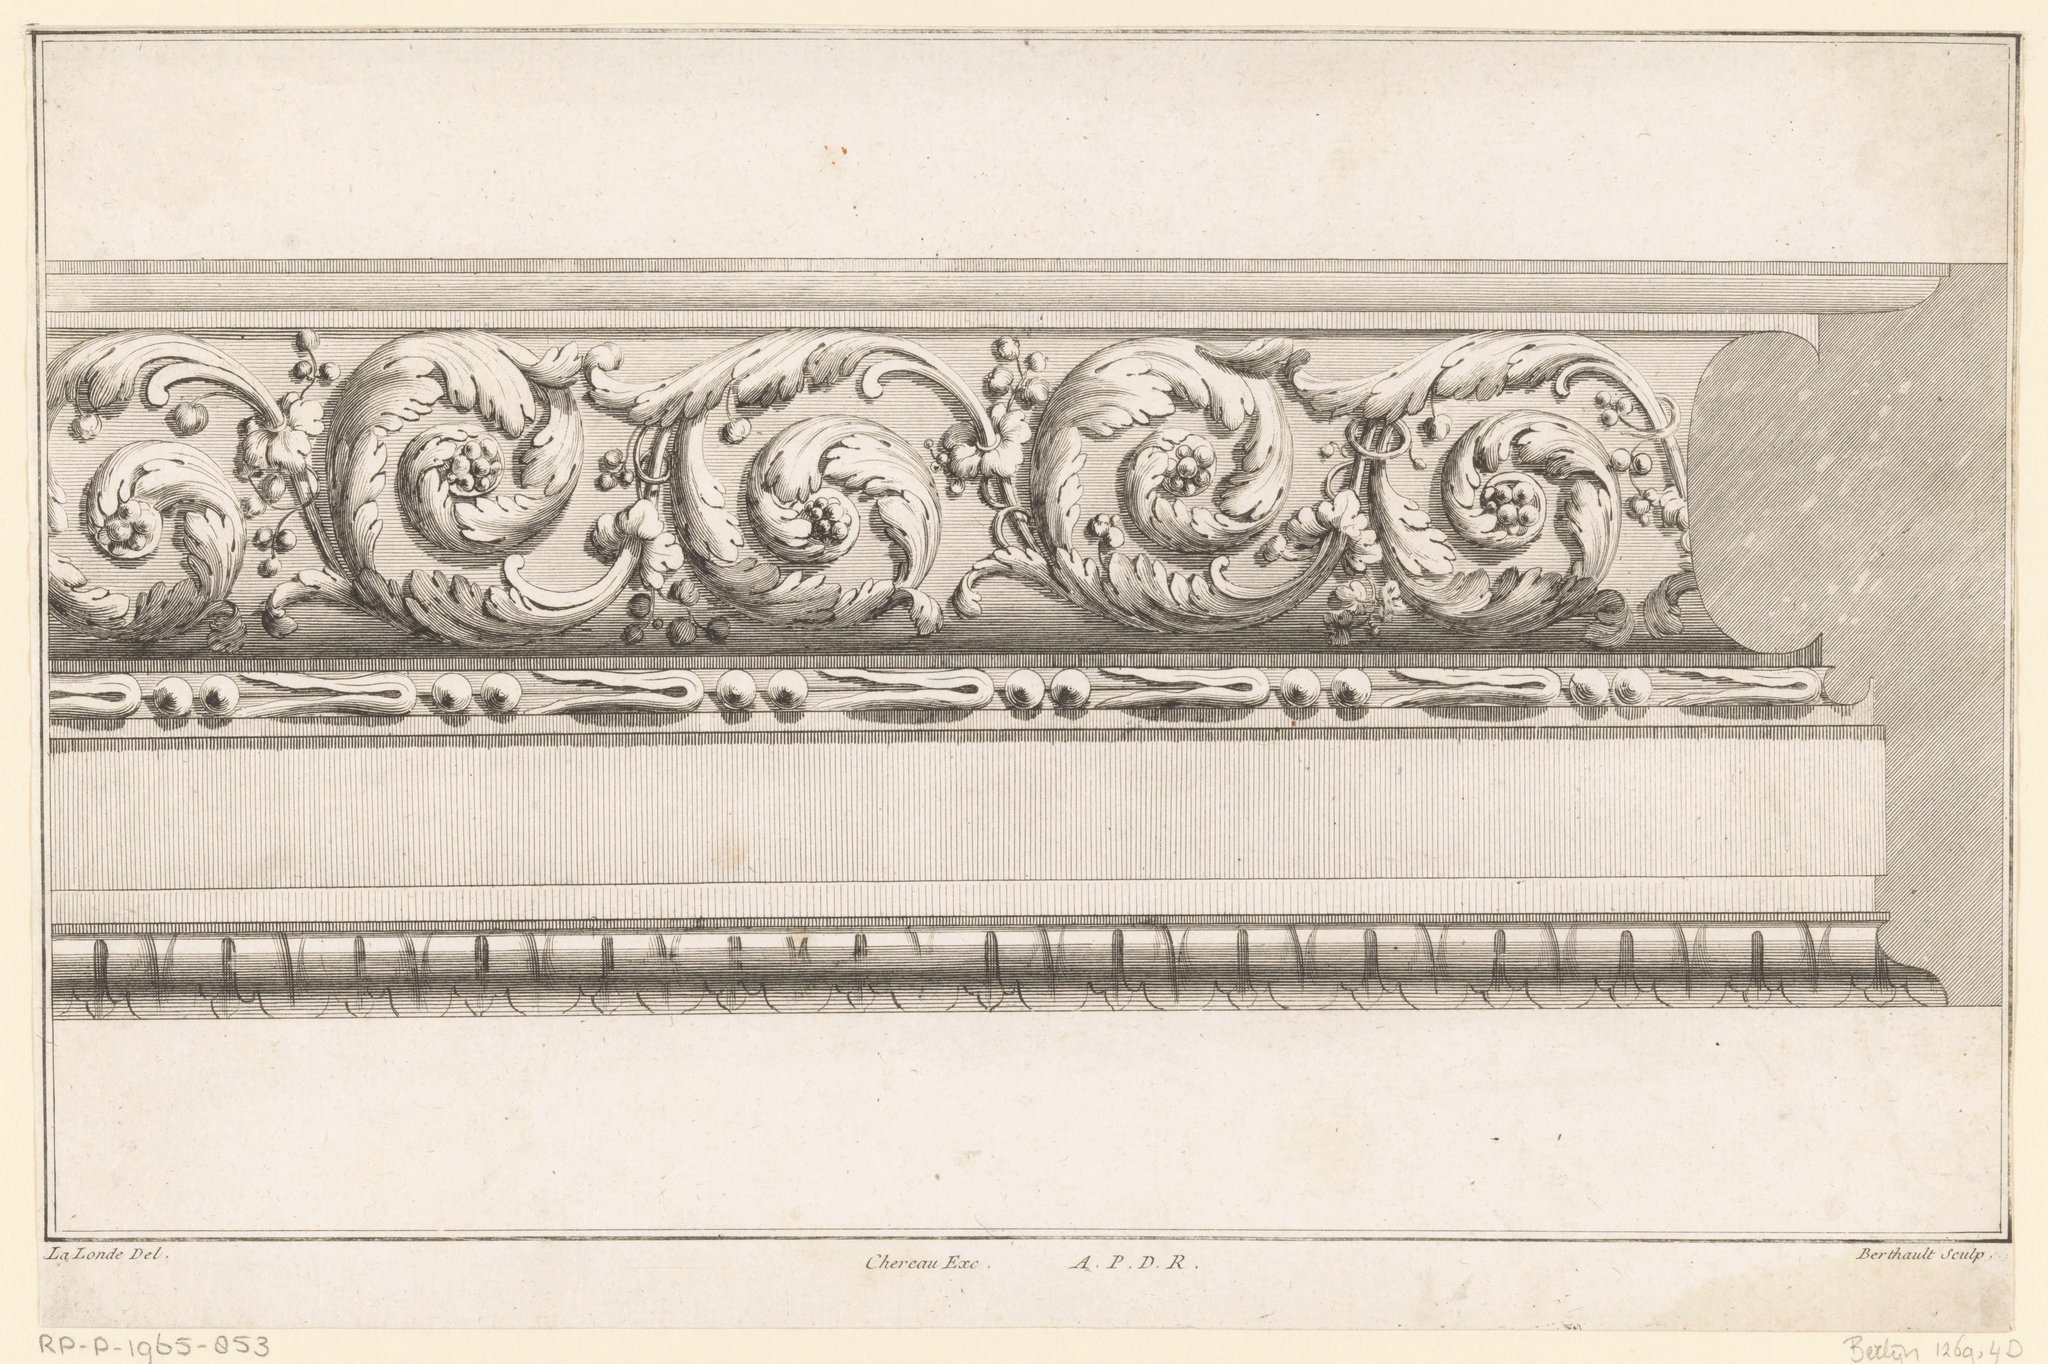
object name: print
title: Lijst blad- en bloemmotieven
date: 1784-1785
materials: paper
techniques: engraving, etching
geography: paris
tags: ornaments ~ art (+ framing decorations)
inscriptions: collector's mark: Lugt 2760, collector's mark: Lugt 2228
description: Een lijst met vlechtwerk van blad- en bloemmotieven.